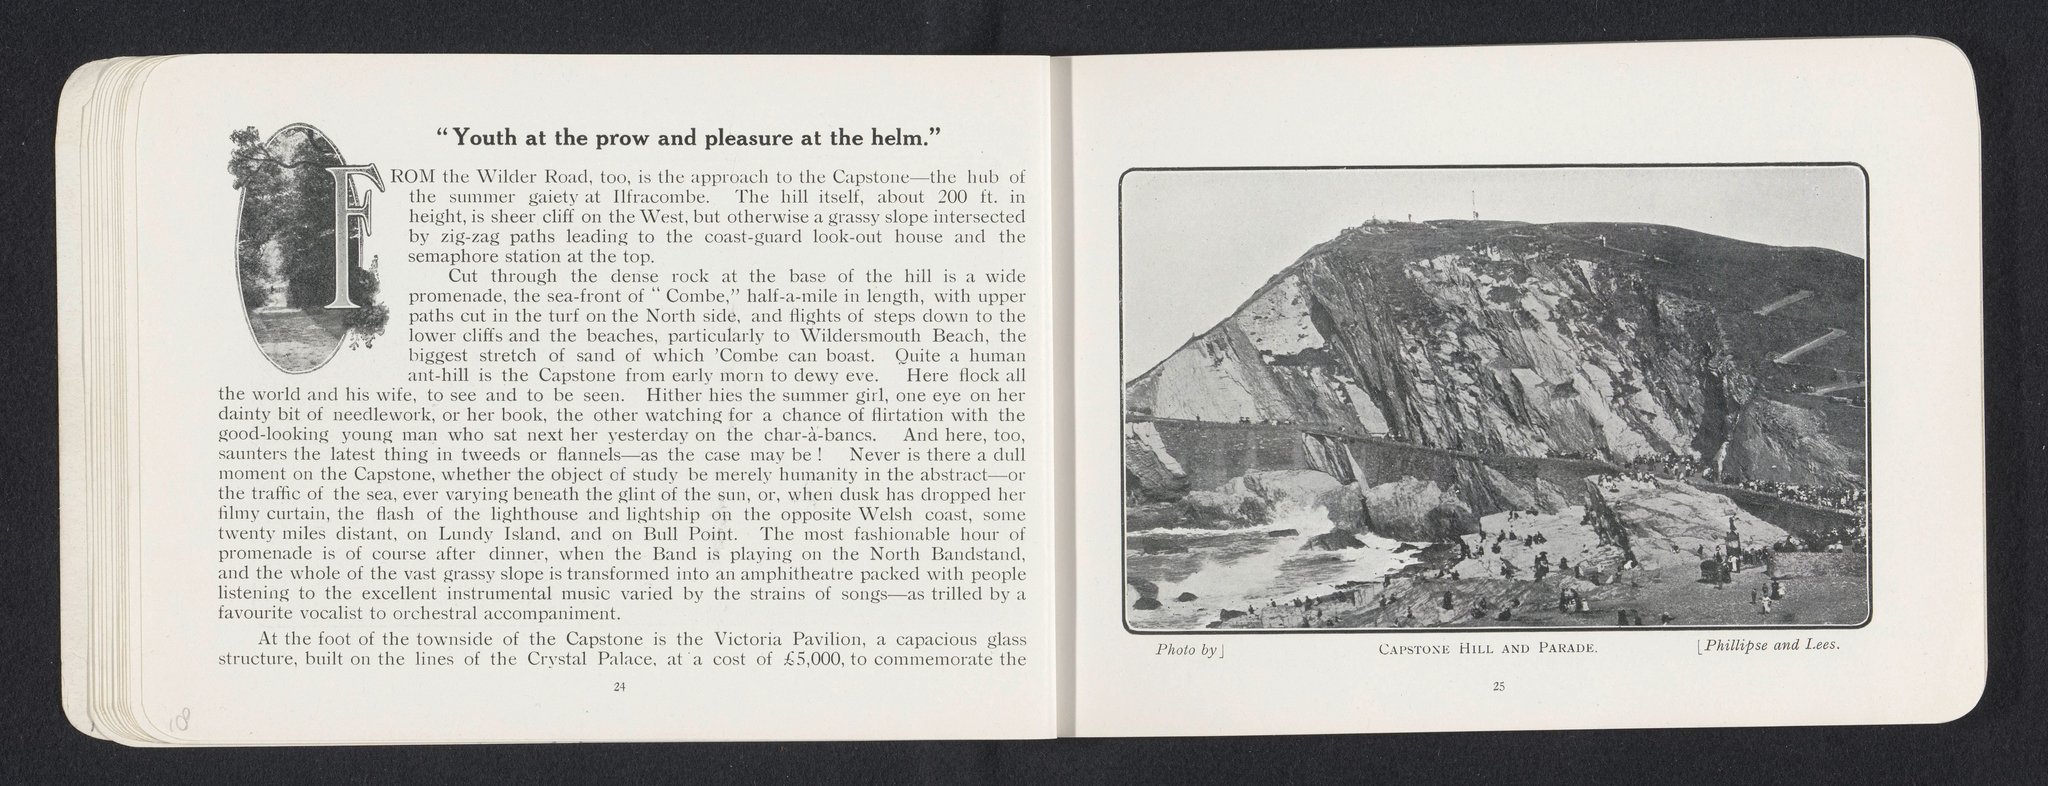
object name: photomechanical print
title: Capstone Hill and Parade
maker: Anonymous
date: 1900-1920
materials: paper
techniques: autotype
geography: ilfracombe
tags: (high) hill